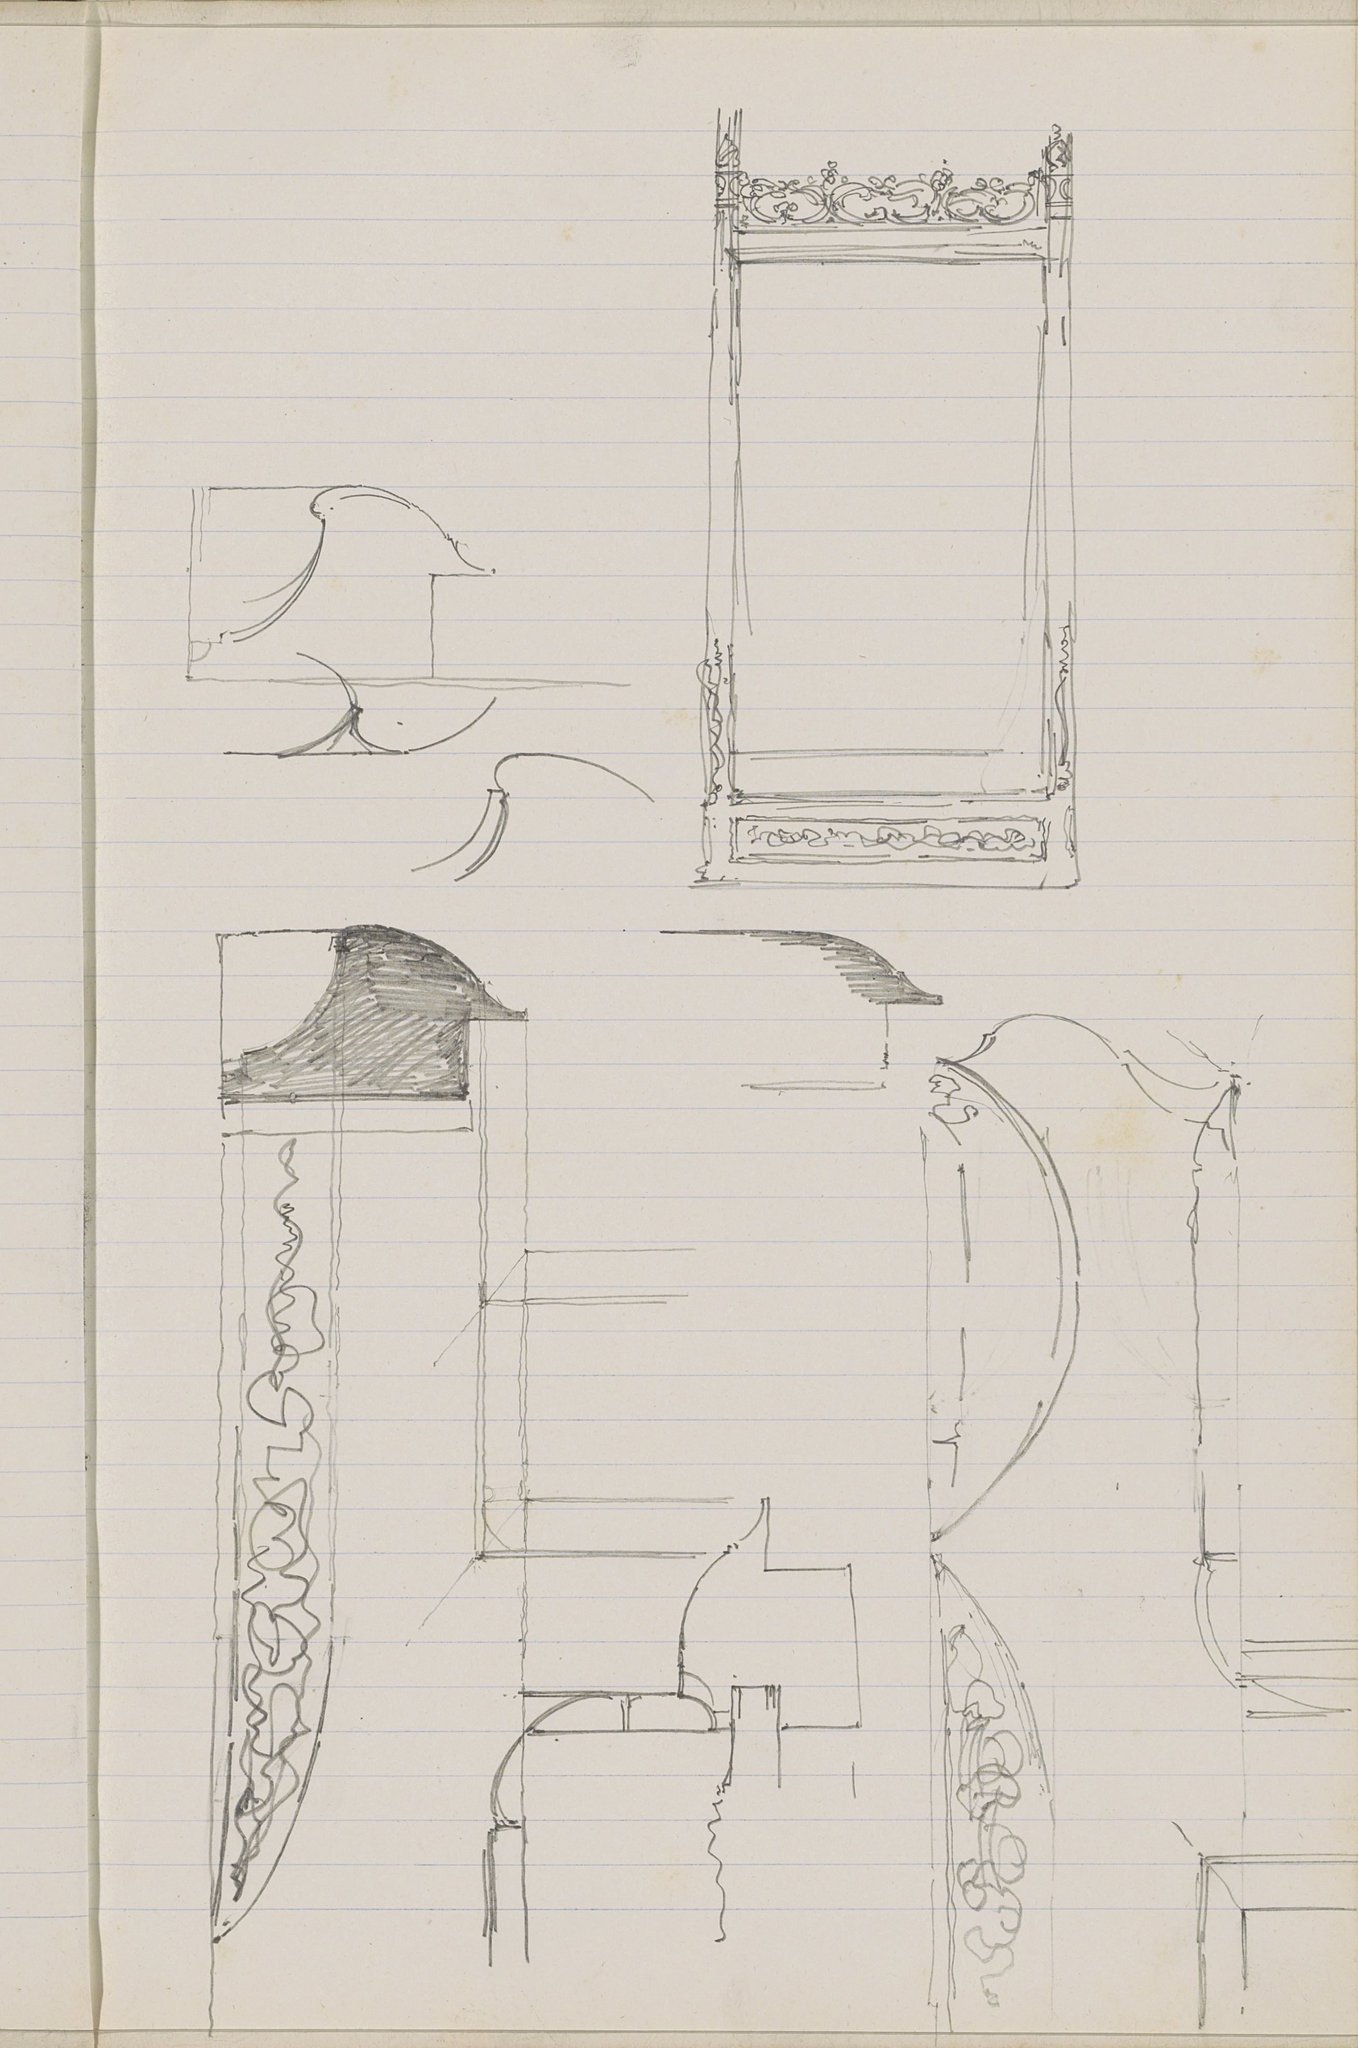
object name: sketchbook leaf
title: Meubilair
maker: gerrit willem dijsselhof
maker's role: designer, draughtsman, print maker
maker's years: 1866-1924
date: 1901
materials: pencil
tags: furniture and household effects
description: Blad 55 recto uit een schetsboek met 79 bladen.